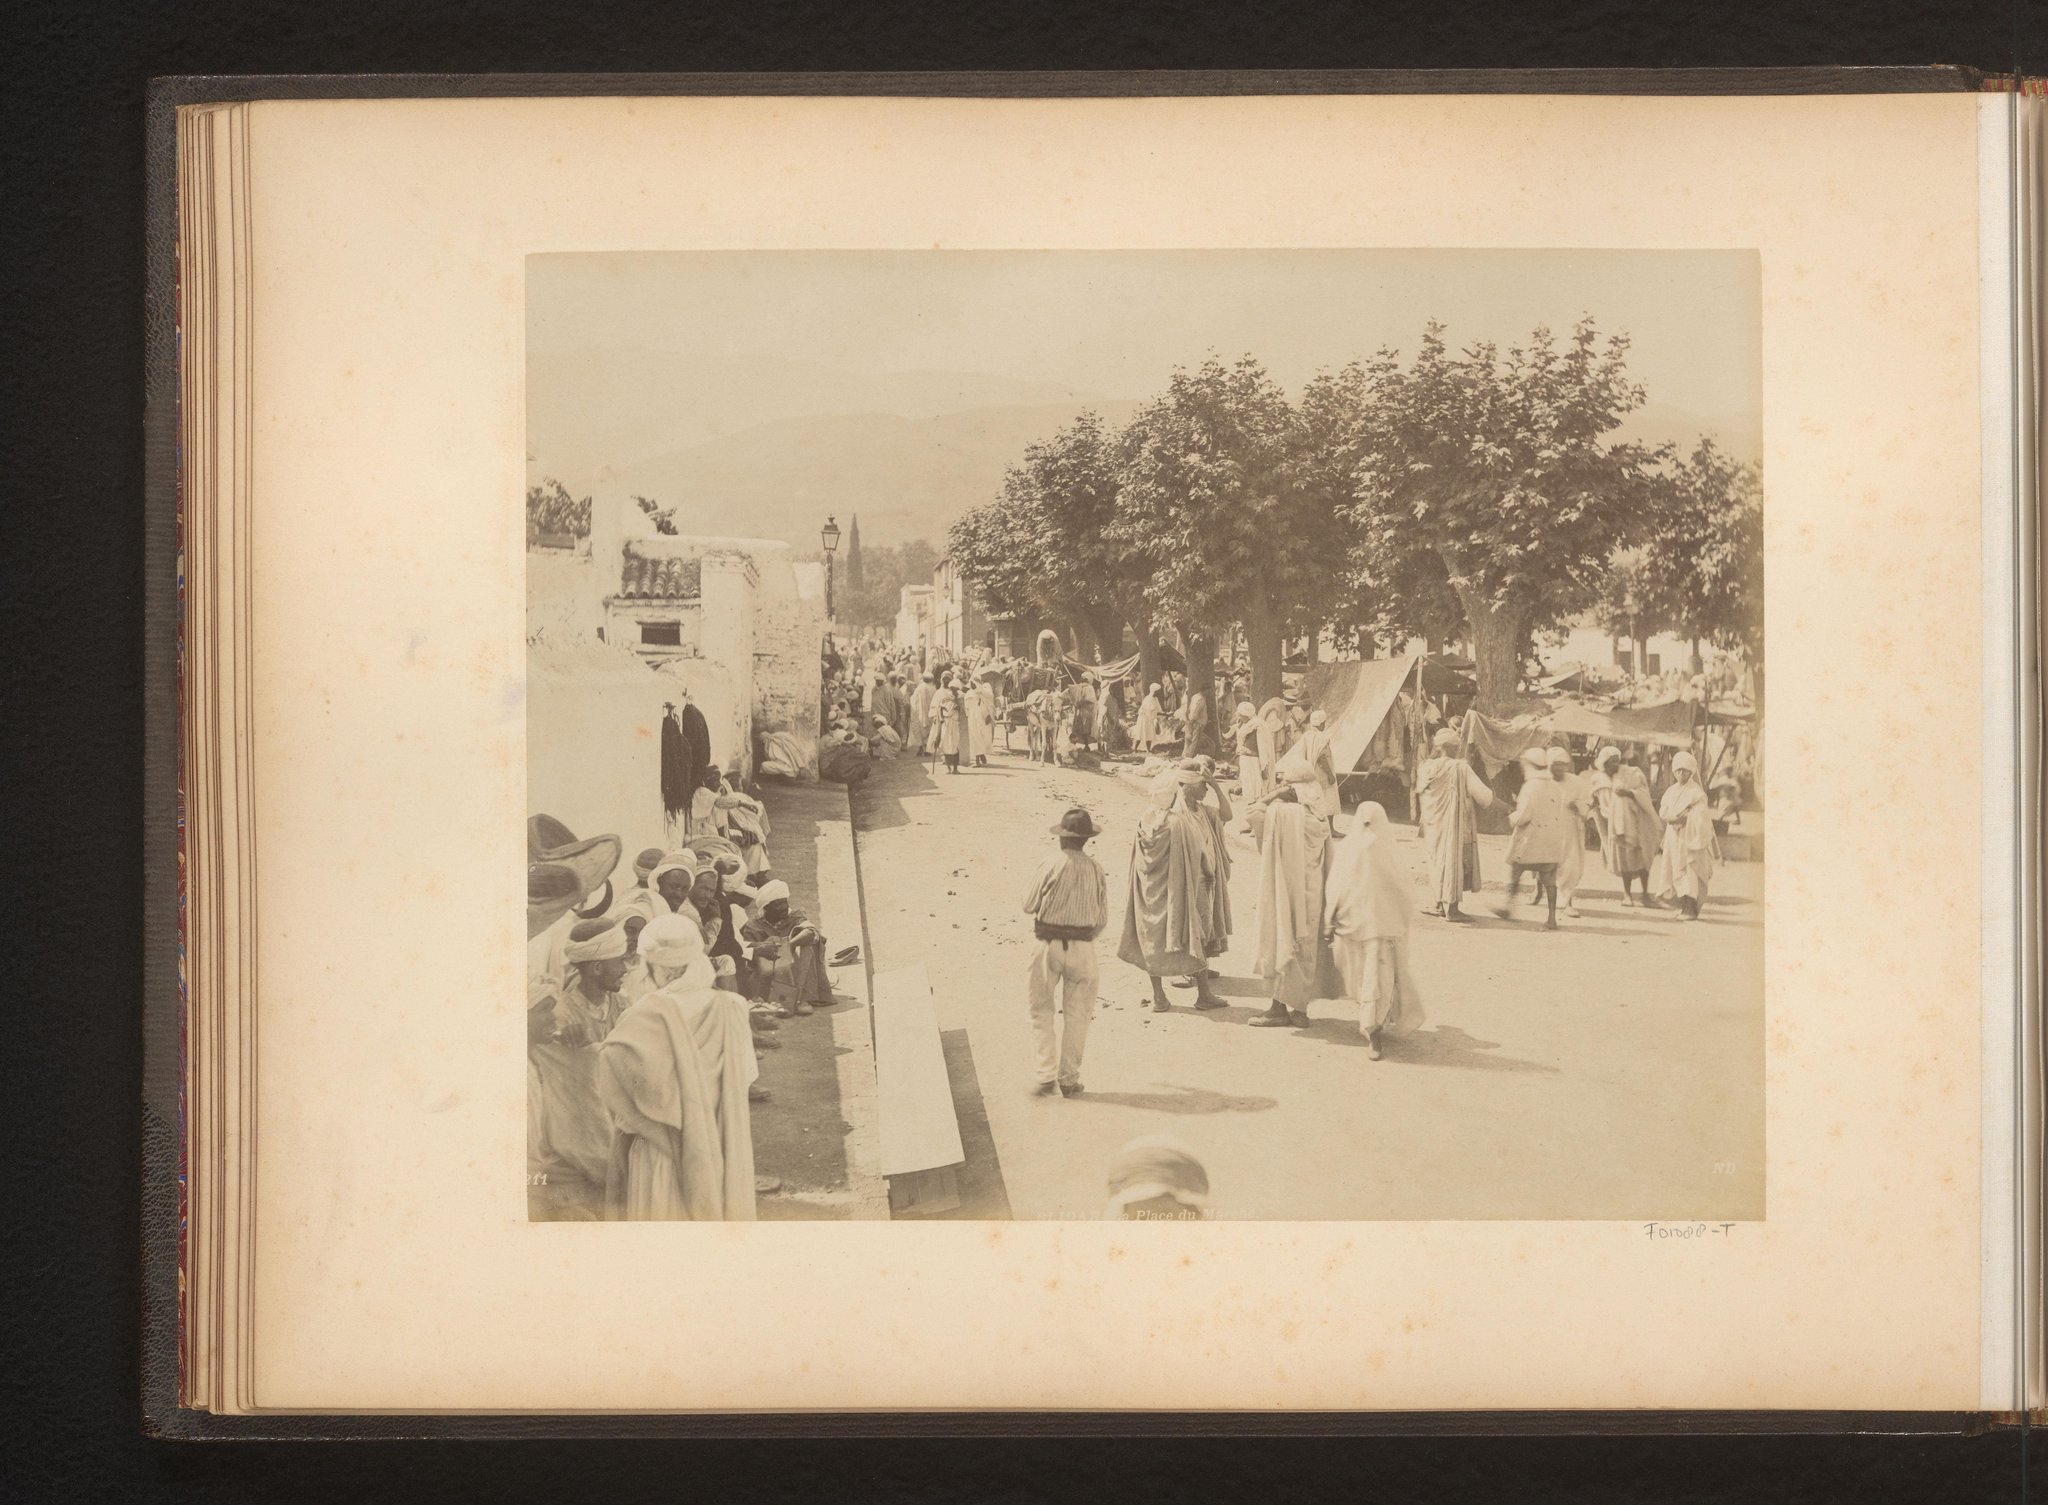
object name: album leaf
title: Blidah La Place du Marche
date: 1880-1900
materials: photographic support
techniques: albumen print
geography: el boulaïda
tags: historical persons, street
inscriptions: number: ‘211’, check stamp: ‘J. Kuhn Editeur/ 220 Rue de Rivoli Paris’